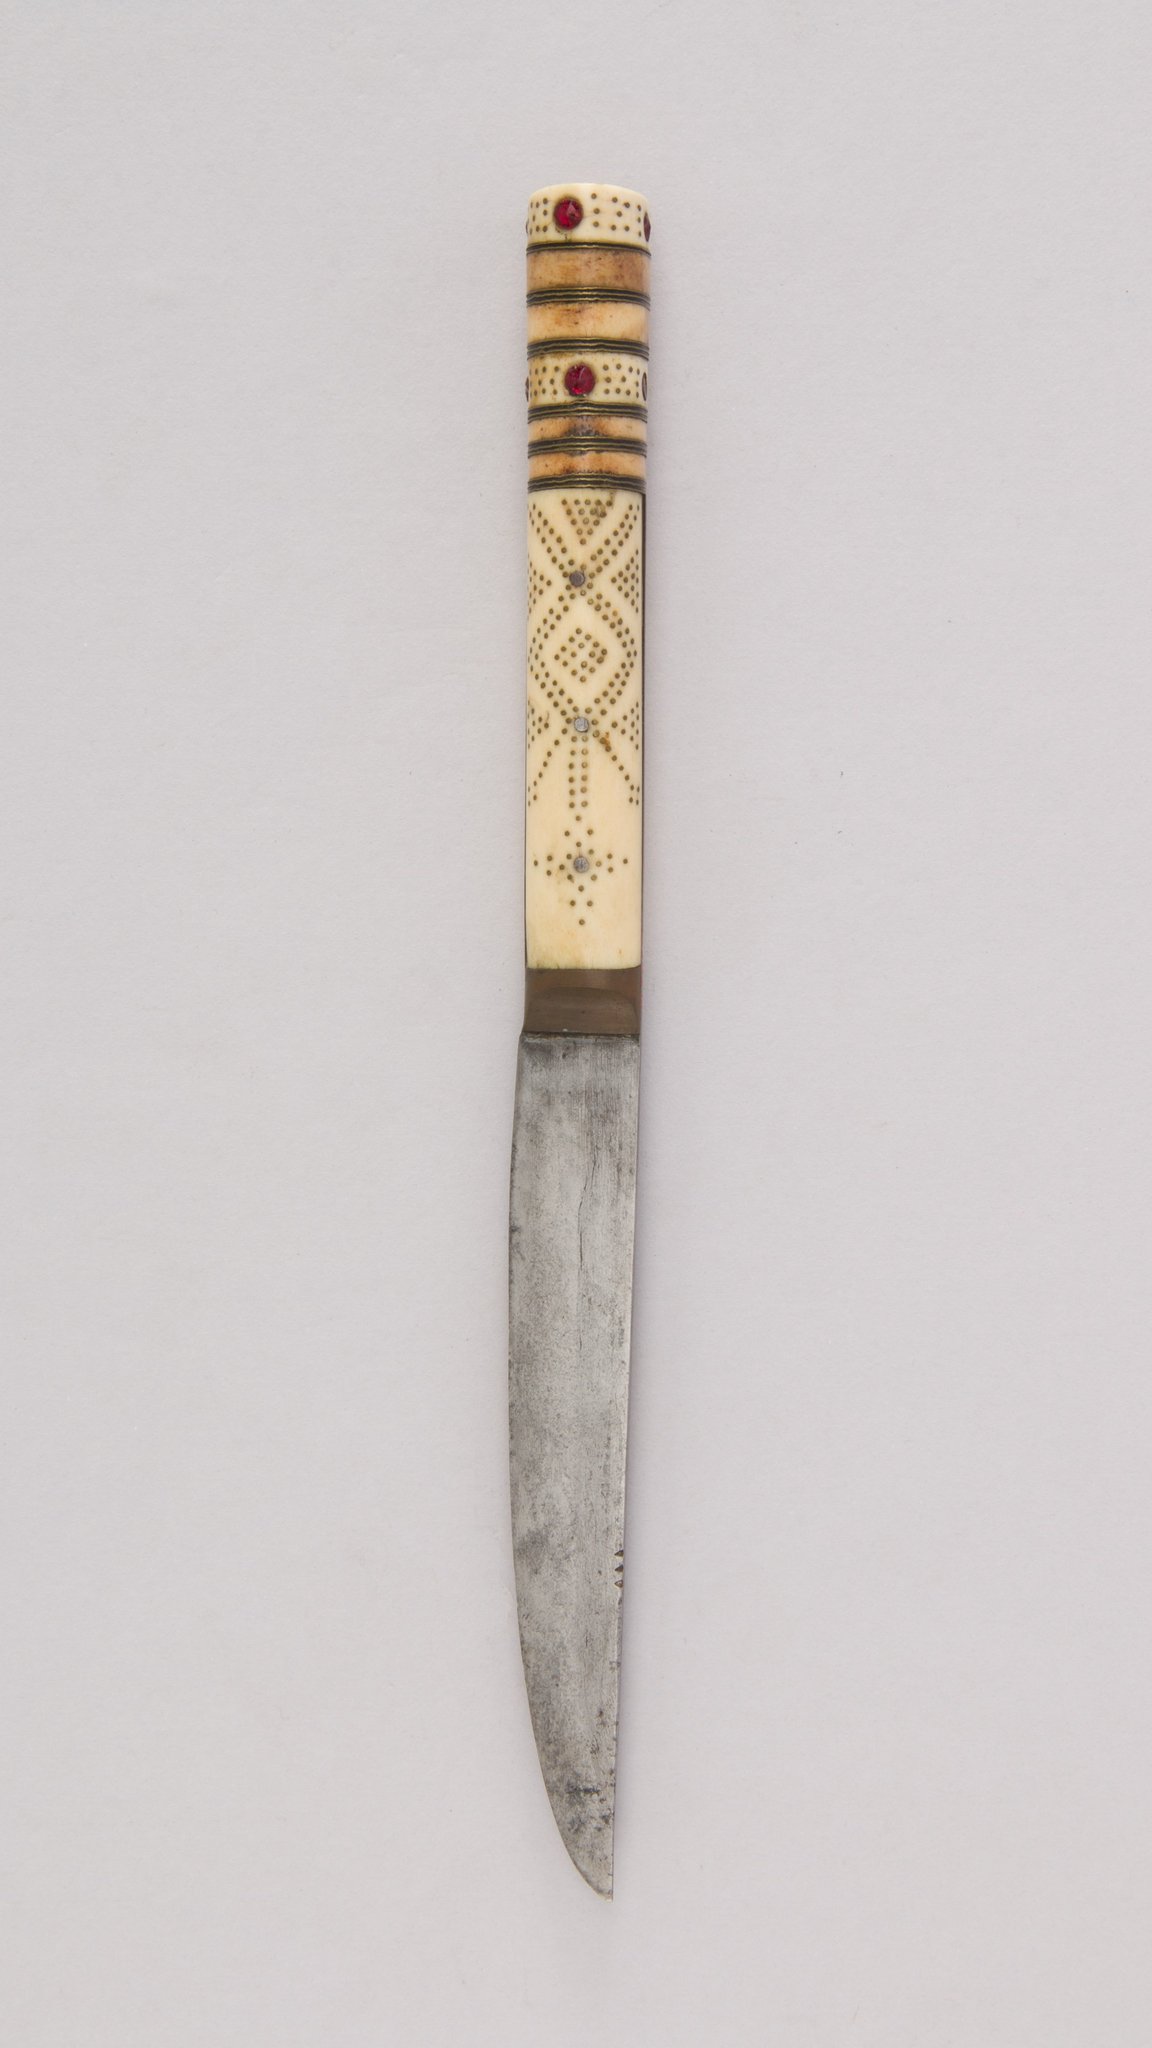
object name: knife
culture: north african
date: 1801-1900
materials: bone, brass, copper alloy, ivory, gemstone, steel, pigment, wax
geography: north africa